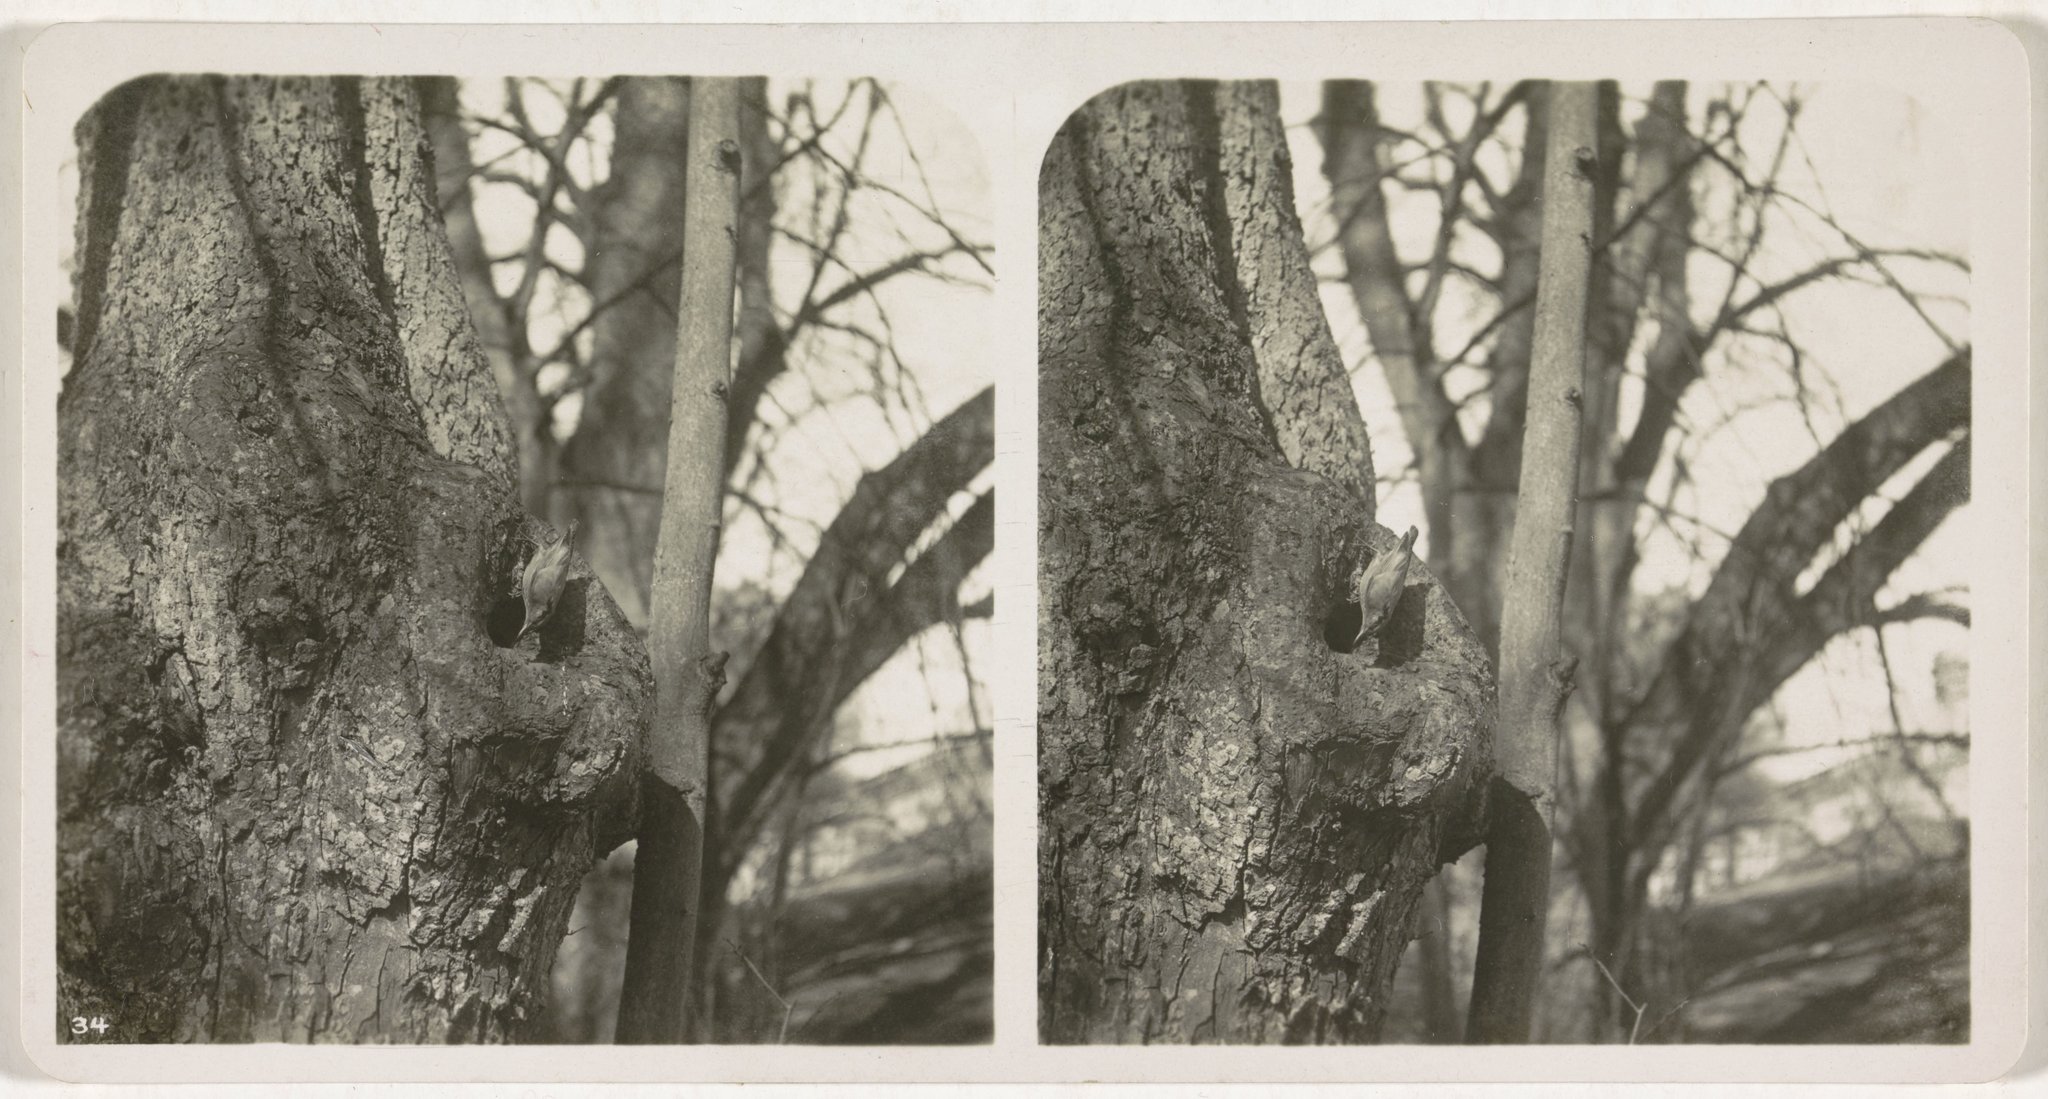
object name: stereograph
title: Boomklever bij ingang van nest in boomstam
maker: adolphe burdet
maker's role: fotograaf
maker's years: 1860-1940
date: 1870-1940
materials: photographic support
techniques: gelatin silver print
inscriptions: label: ‘34 / Sitta caesia Meyer u. Wolf / Sittelle / Boomklever...’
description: Linksonder op de foto links staat het nummer 34. Uit serie van 25 stereofoto's.